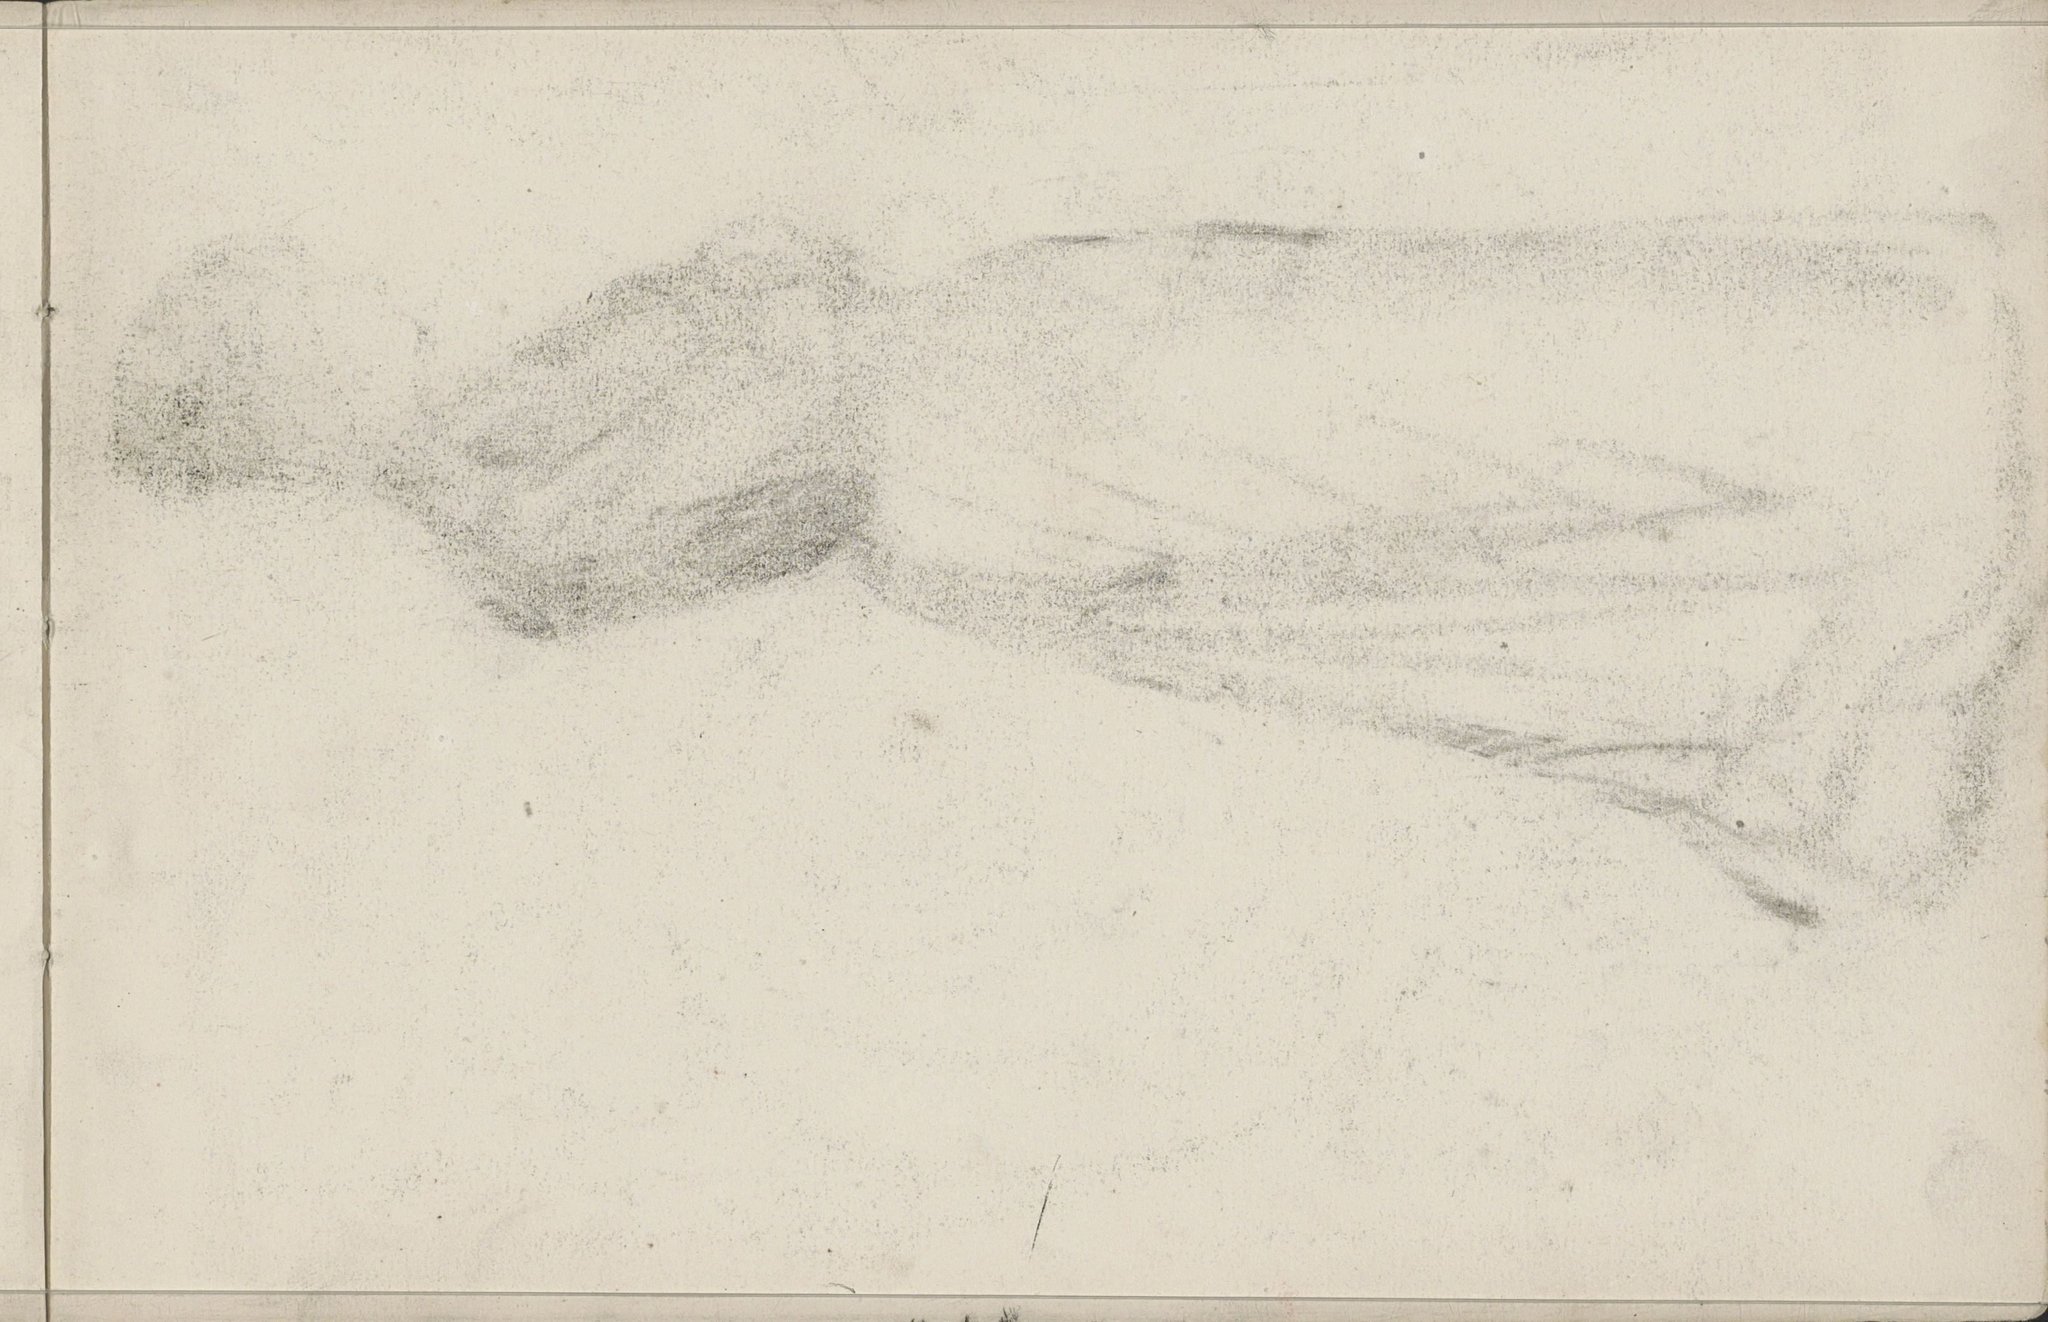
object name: sketchbook leaf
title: Abklatsch van een krijttekening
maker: carel adolph lion cachet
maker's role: draughtsman, print maker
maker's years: 1864-1945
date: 1895-1900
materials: paper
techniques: printmaking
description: Abklatsch van een tekening van een staande vrouw in een lange jurk die niet langer in het schetsboek aanwezig is. Blad 17 recto uit een schetsboek met 19 bladen.